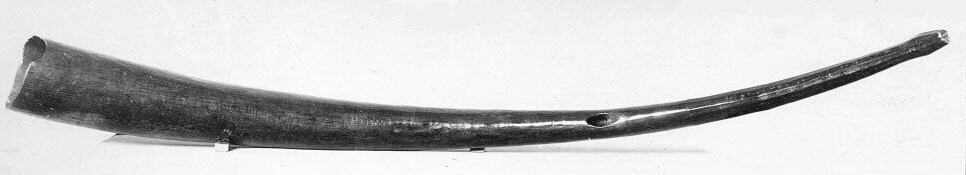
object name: horn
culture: african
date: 1867-1900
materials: ivory